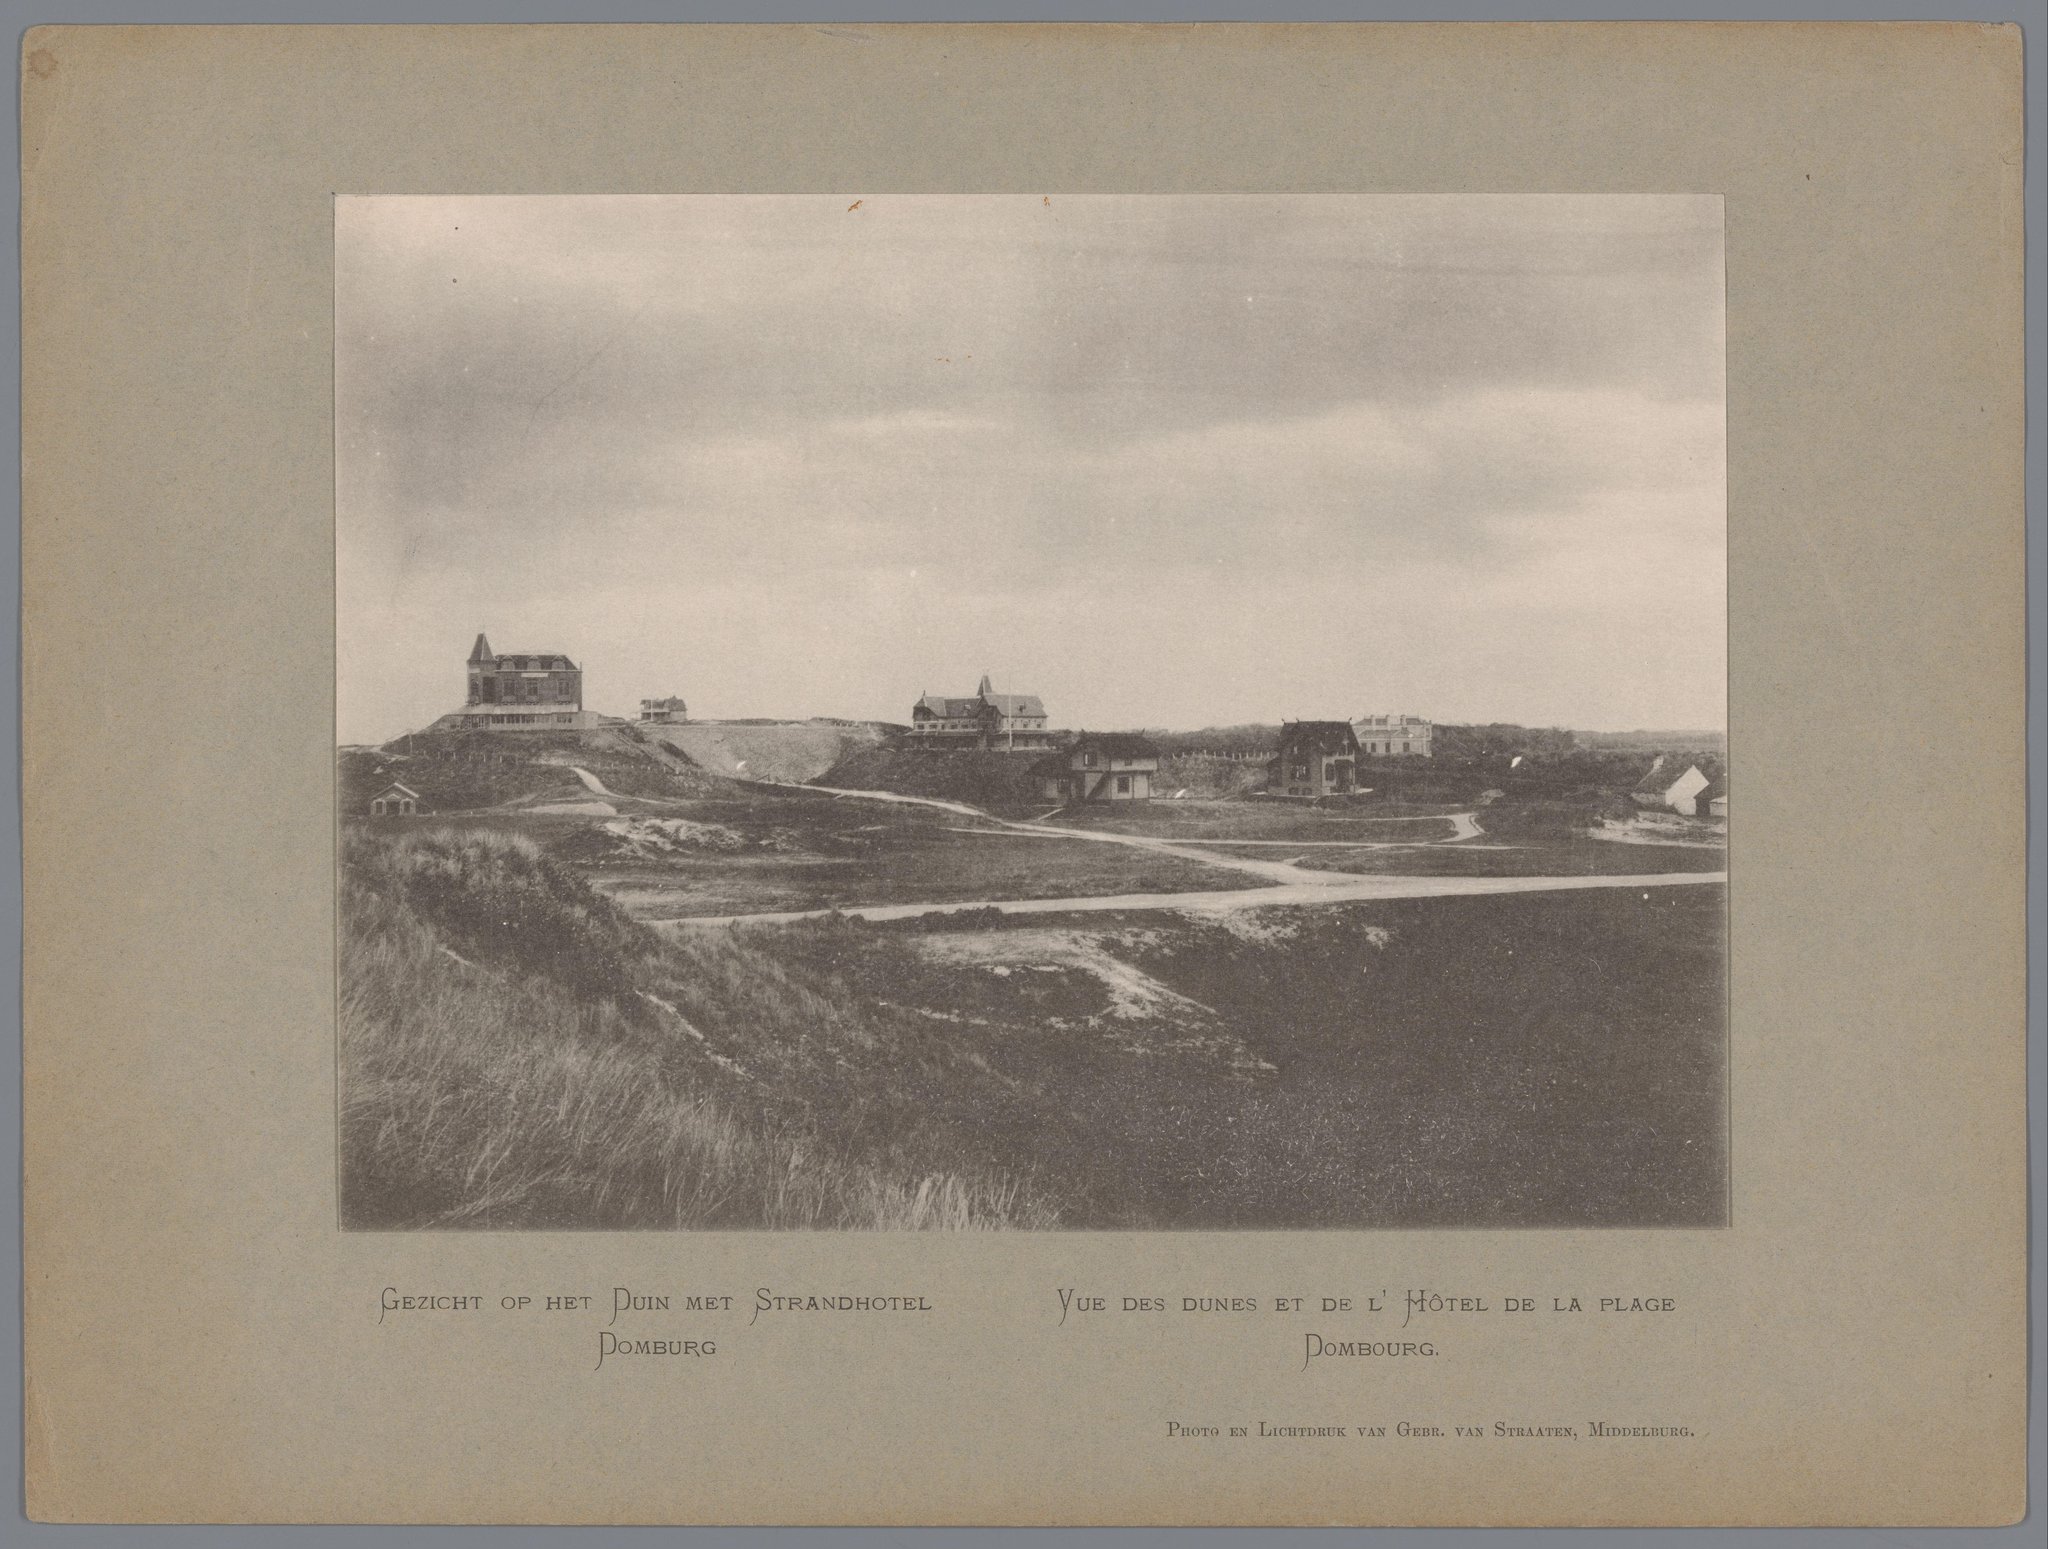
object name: photomechanical print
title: Gezicht op de duinen en het Strandhotel in Domburg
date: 1880-1940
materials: paper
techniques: photograph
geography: middelburg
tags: dune coast, hotel, hostelry, inn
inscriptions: collector's mark: ‘Vosmaer’